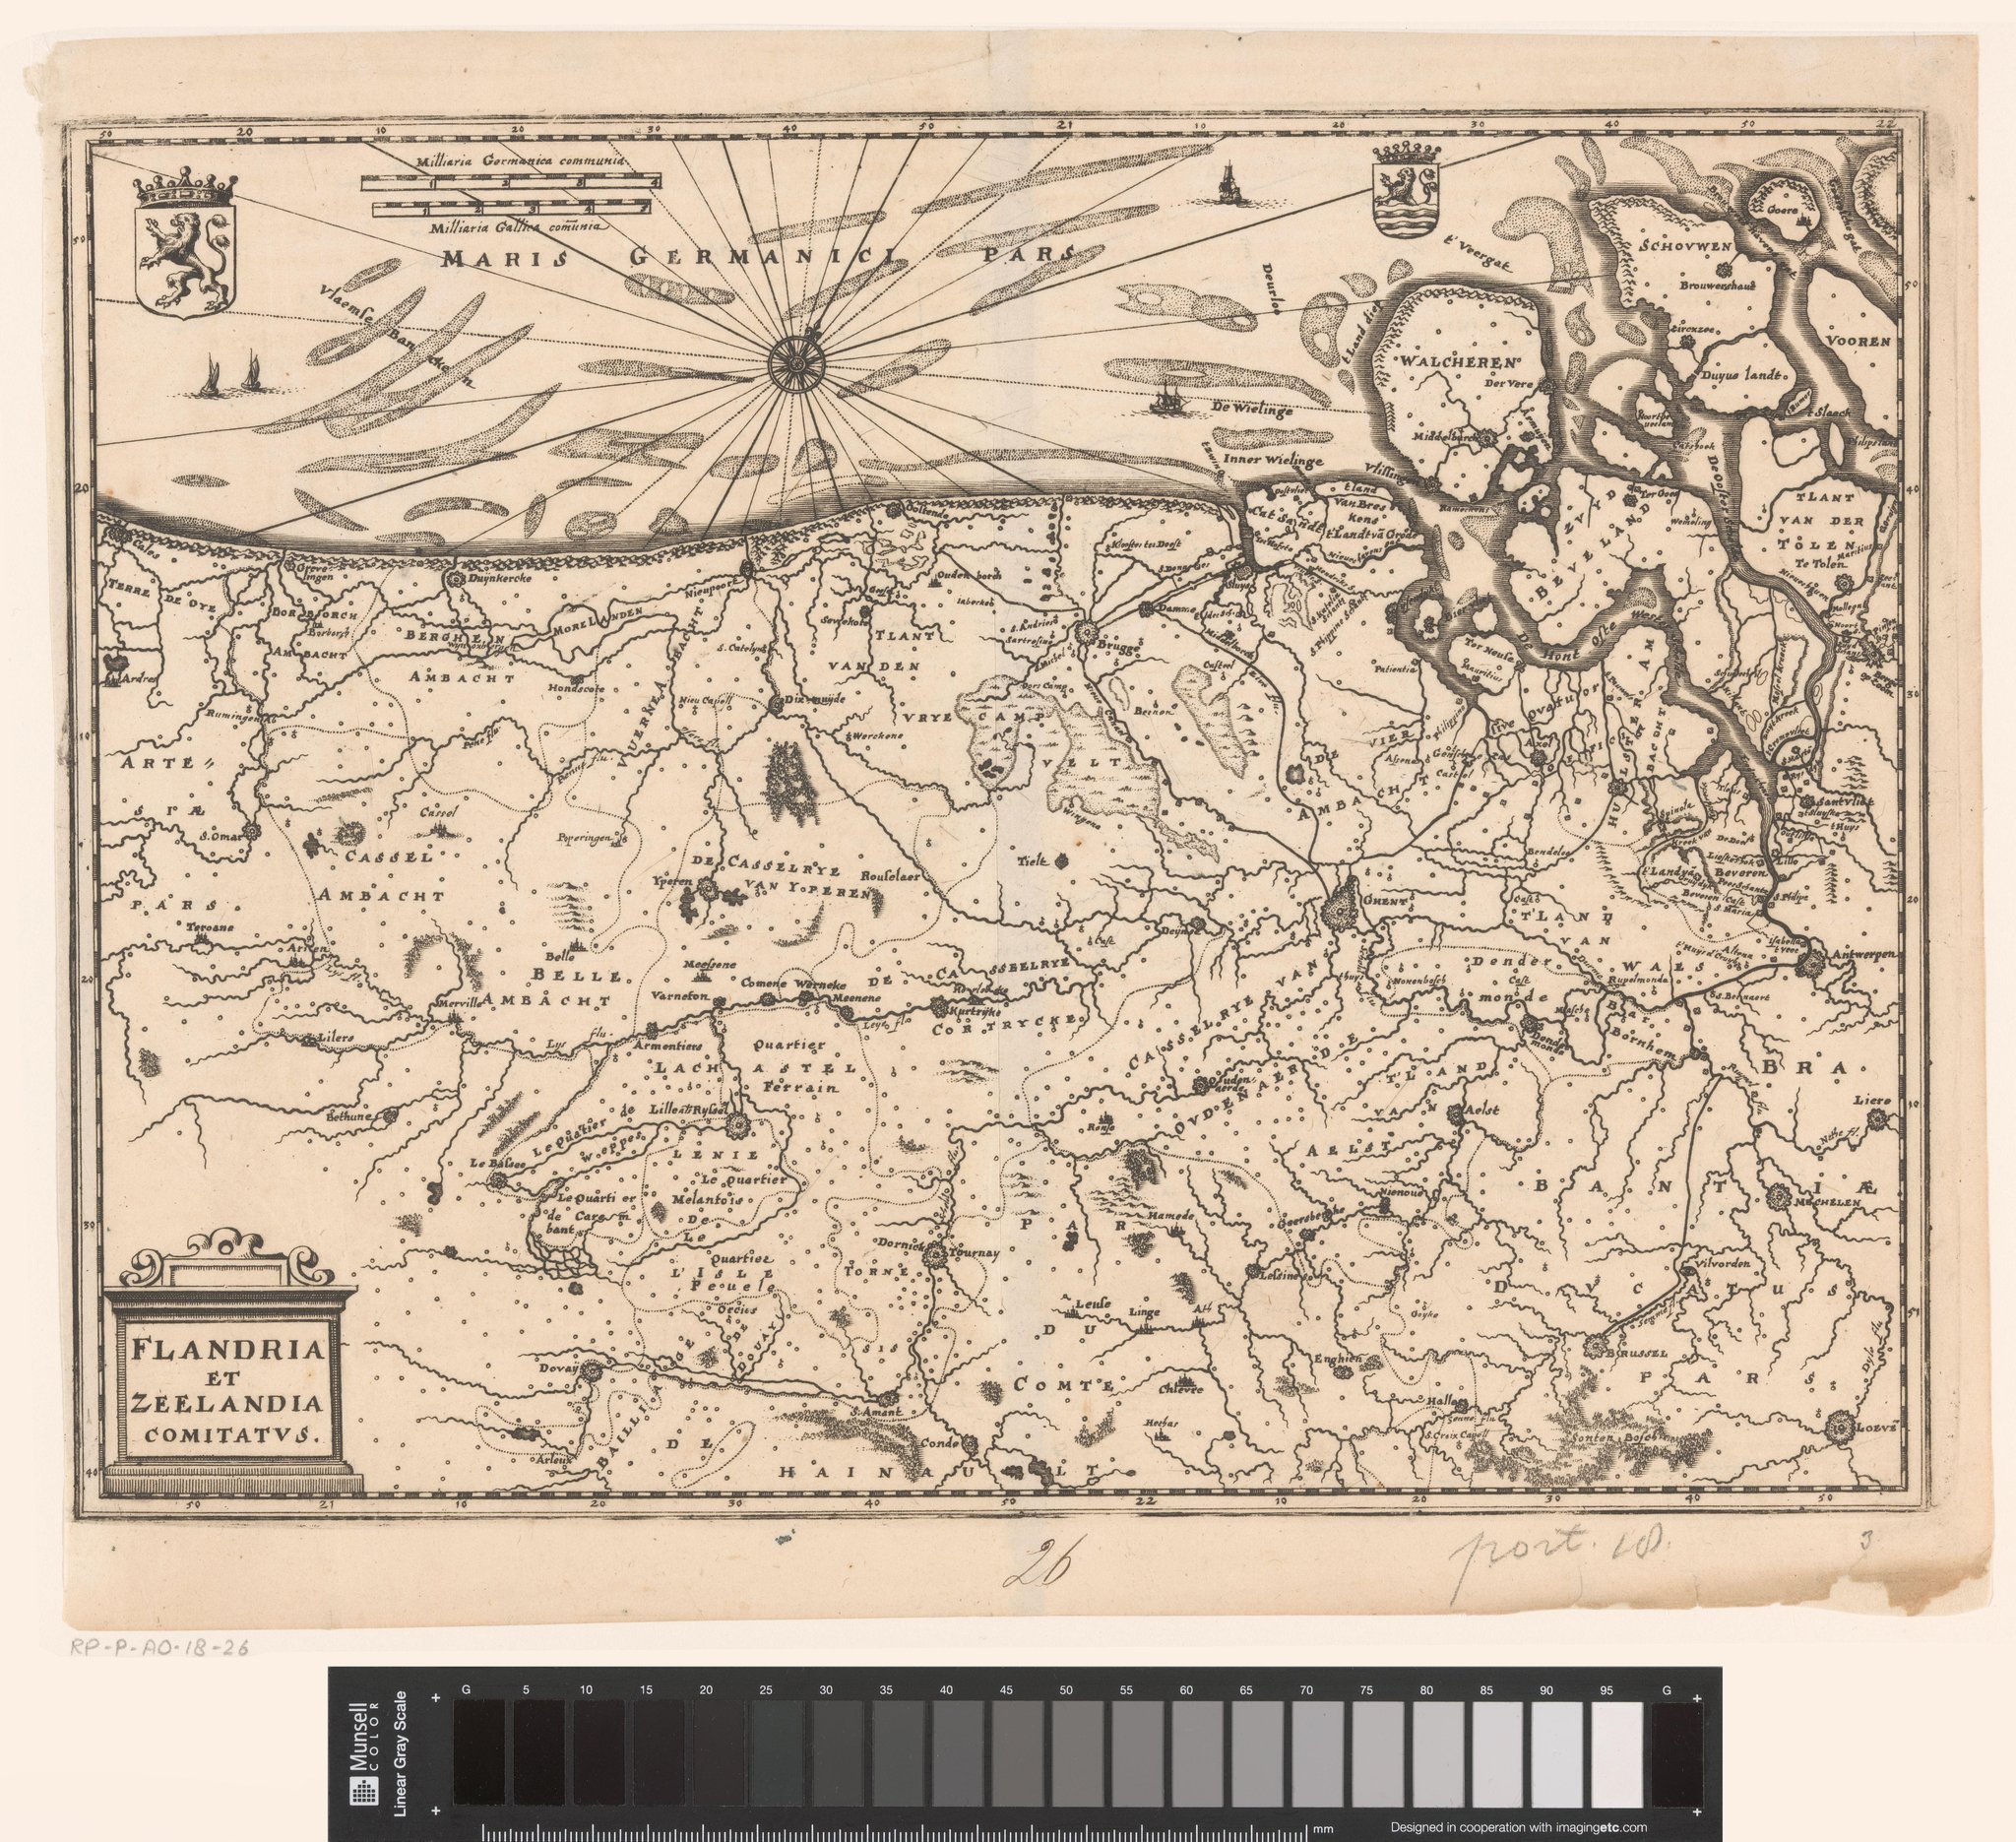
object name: print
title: Kaart van de graafschappen Vlaanderen en Zeeland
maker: caspar merian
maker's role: print maker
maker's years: 1627-1689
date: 1654-1700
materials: paper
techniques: engraving, etching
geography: frankfurt am main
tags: maps of separate countries or regions, coat of arms (as symbol of the state, etc.) (+ province; provincial), zeeland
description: Prent gebruikt in: Zeiller, Martin. M.Z. Topographia Circuli Burgundici Oder Beschreibung une Eigentliche Abbildung der Vornehmsten Örter in dem Hochlöblichen Burgund- un Niderlandischen Crayse. Frankfurt am Main: Caspar Merian, 1654. Of in: Zeiller, Martin. M. Z. Topographia Germaniae-Inferioris vel Circuli-Burgundici, das ist Beschreibung (…). Frankfurt am Main: Caspar Merian, 1659. Of in een van de twee latere uitgaven van deze publicatie die, hoewel het jaar 1659 erin staat vermeld als jaar van uitgave, zijn uitgegeven in respectievelijk ca. 1670 en ca. 1700.